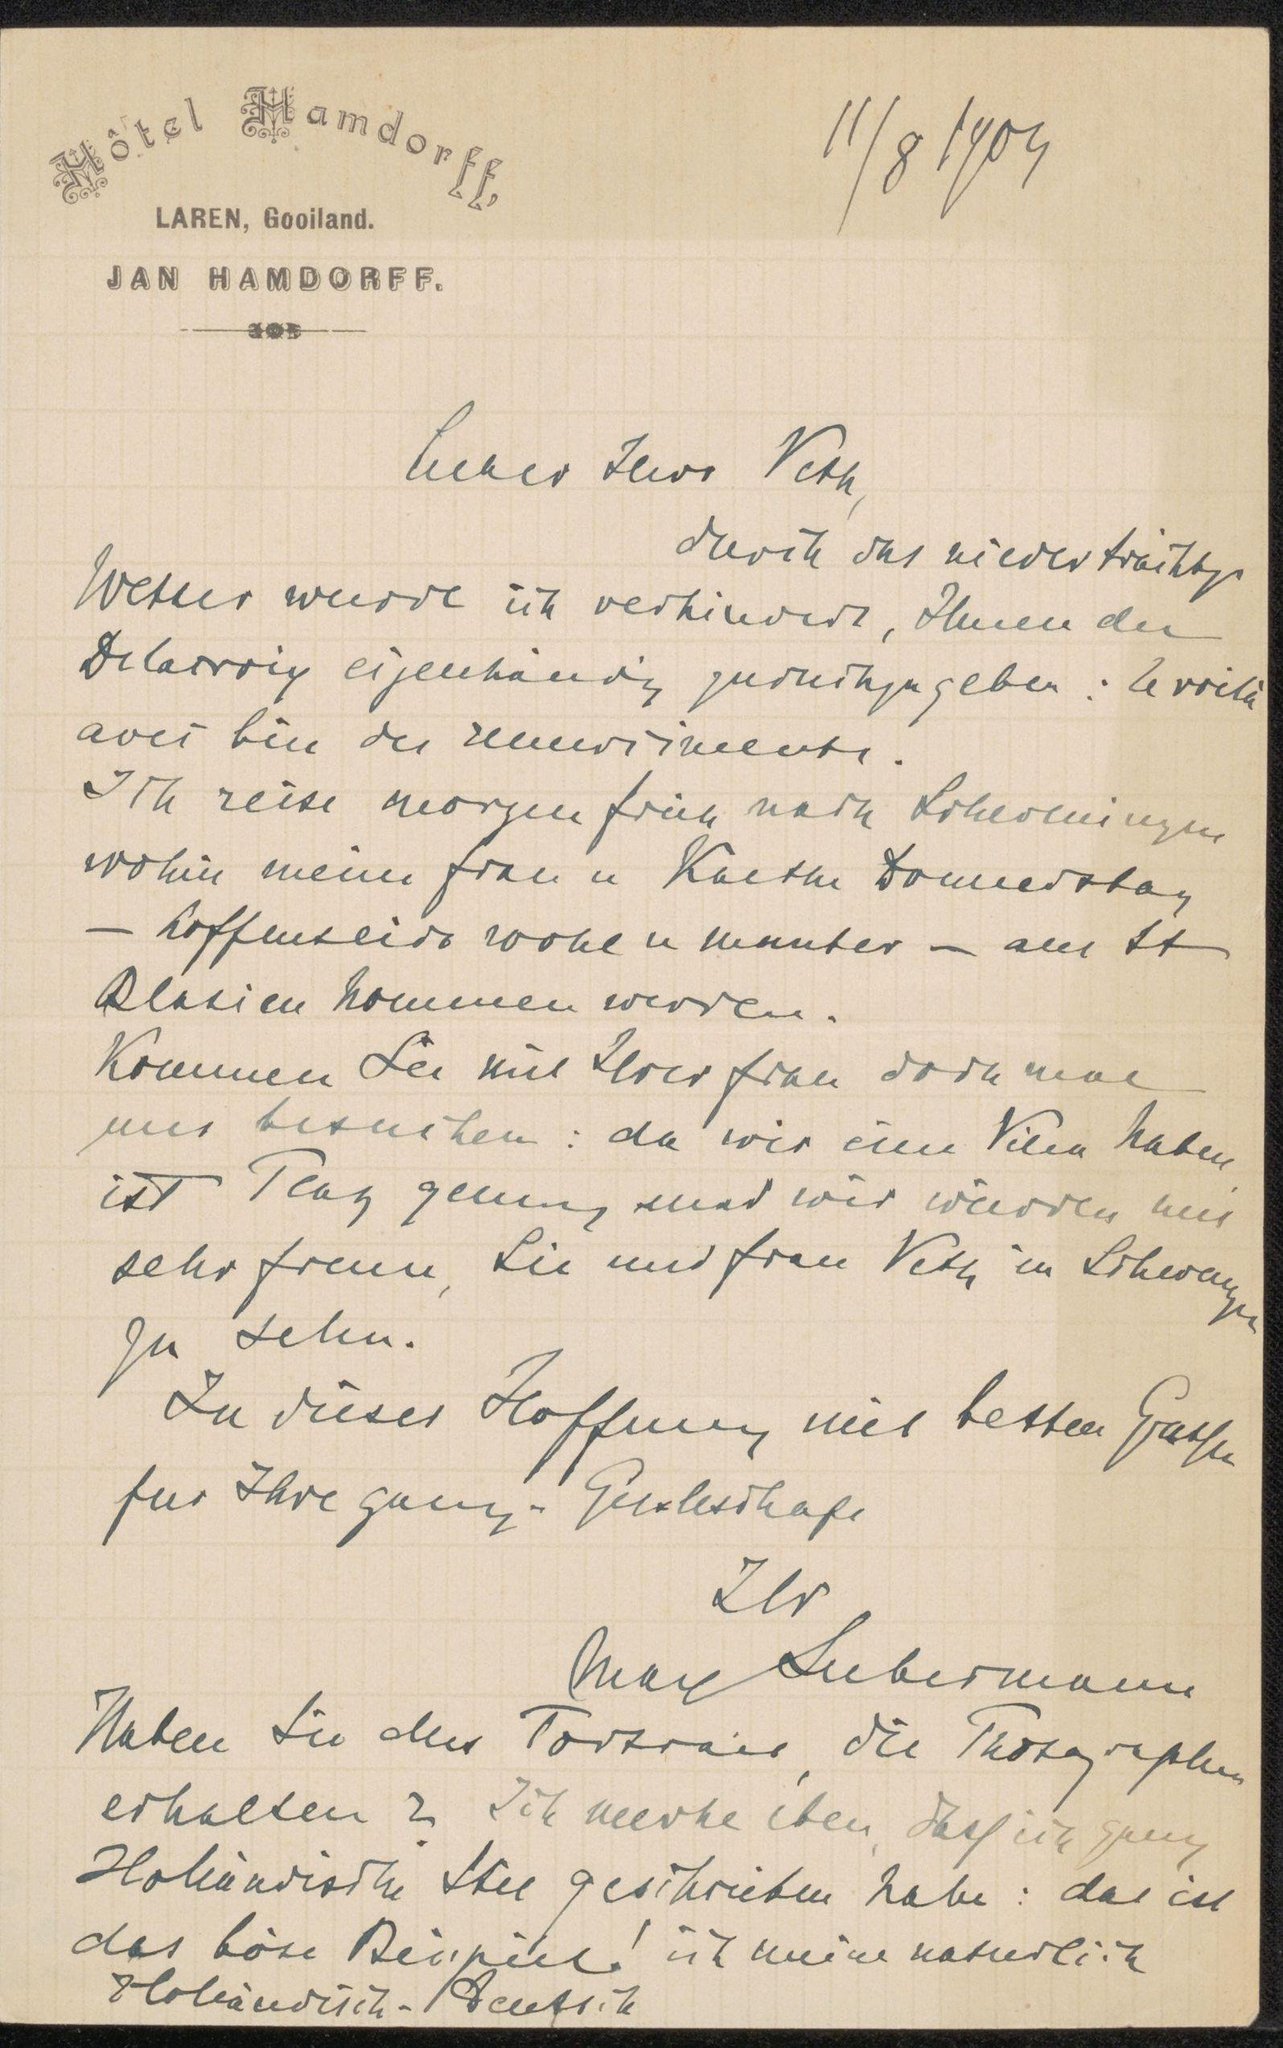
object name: letter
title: Brief aan Jan Veth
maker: max liebermann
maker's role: draughtsman, print maker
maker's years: 1847-1935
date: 1903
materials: ink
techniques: pen, printing, writing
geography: laren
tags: paris, print maker, draughtsman, eugène delacroix, amsterdam, painter, designer, jan veth, photography, cinematography, historical persons (portraits and scenes from the life)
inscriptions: collector's mark: ‘RPK’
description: Opgenomen in: Ernst Braun, Max Liebermann: Briefe 1902-1906, Baden-Baden: Deutscher Wissenschafts-Verlag, 2013, Band 3, p. 124.